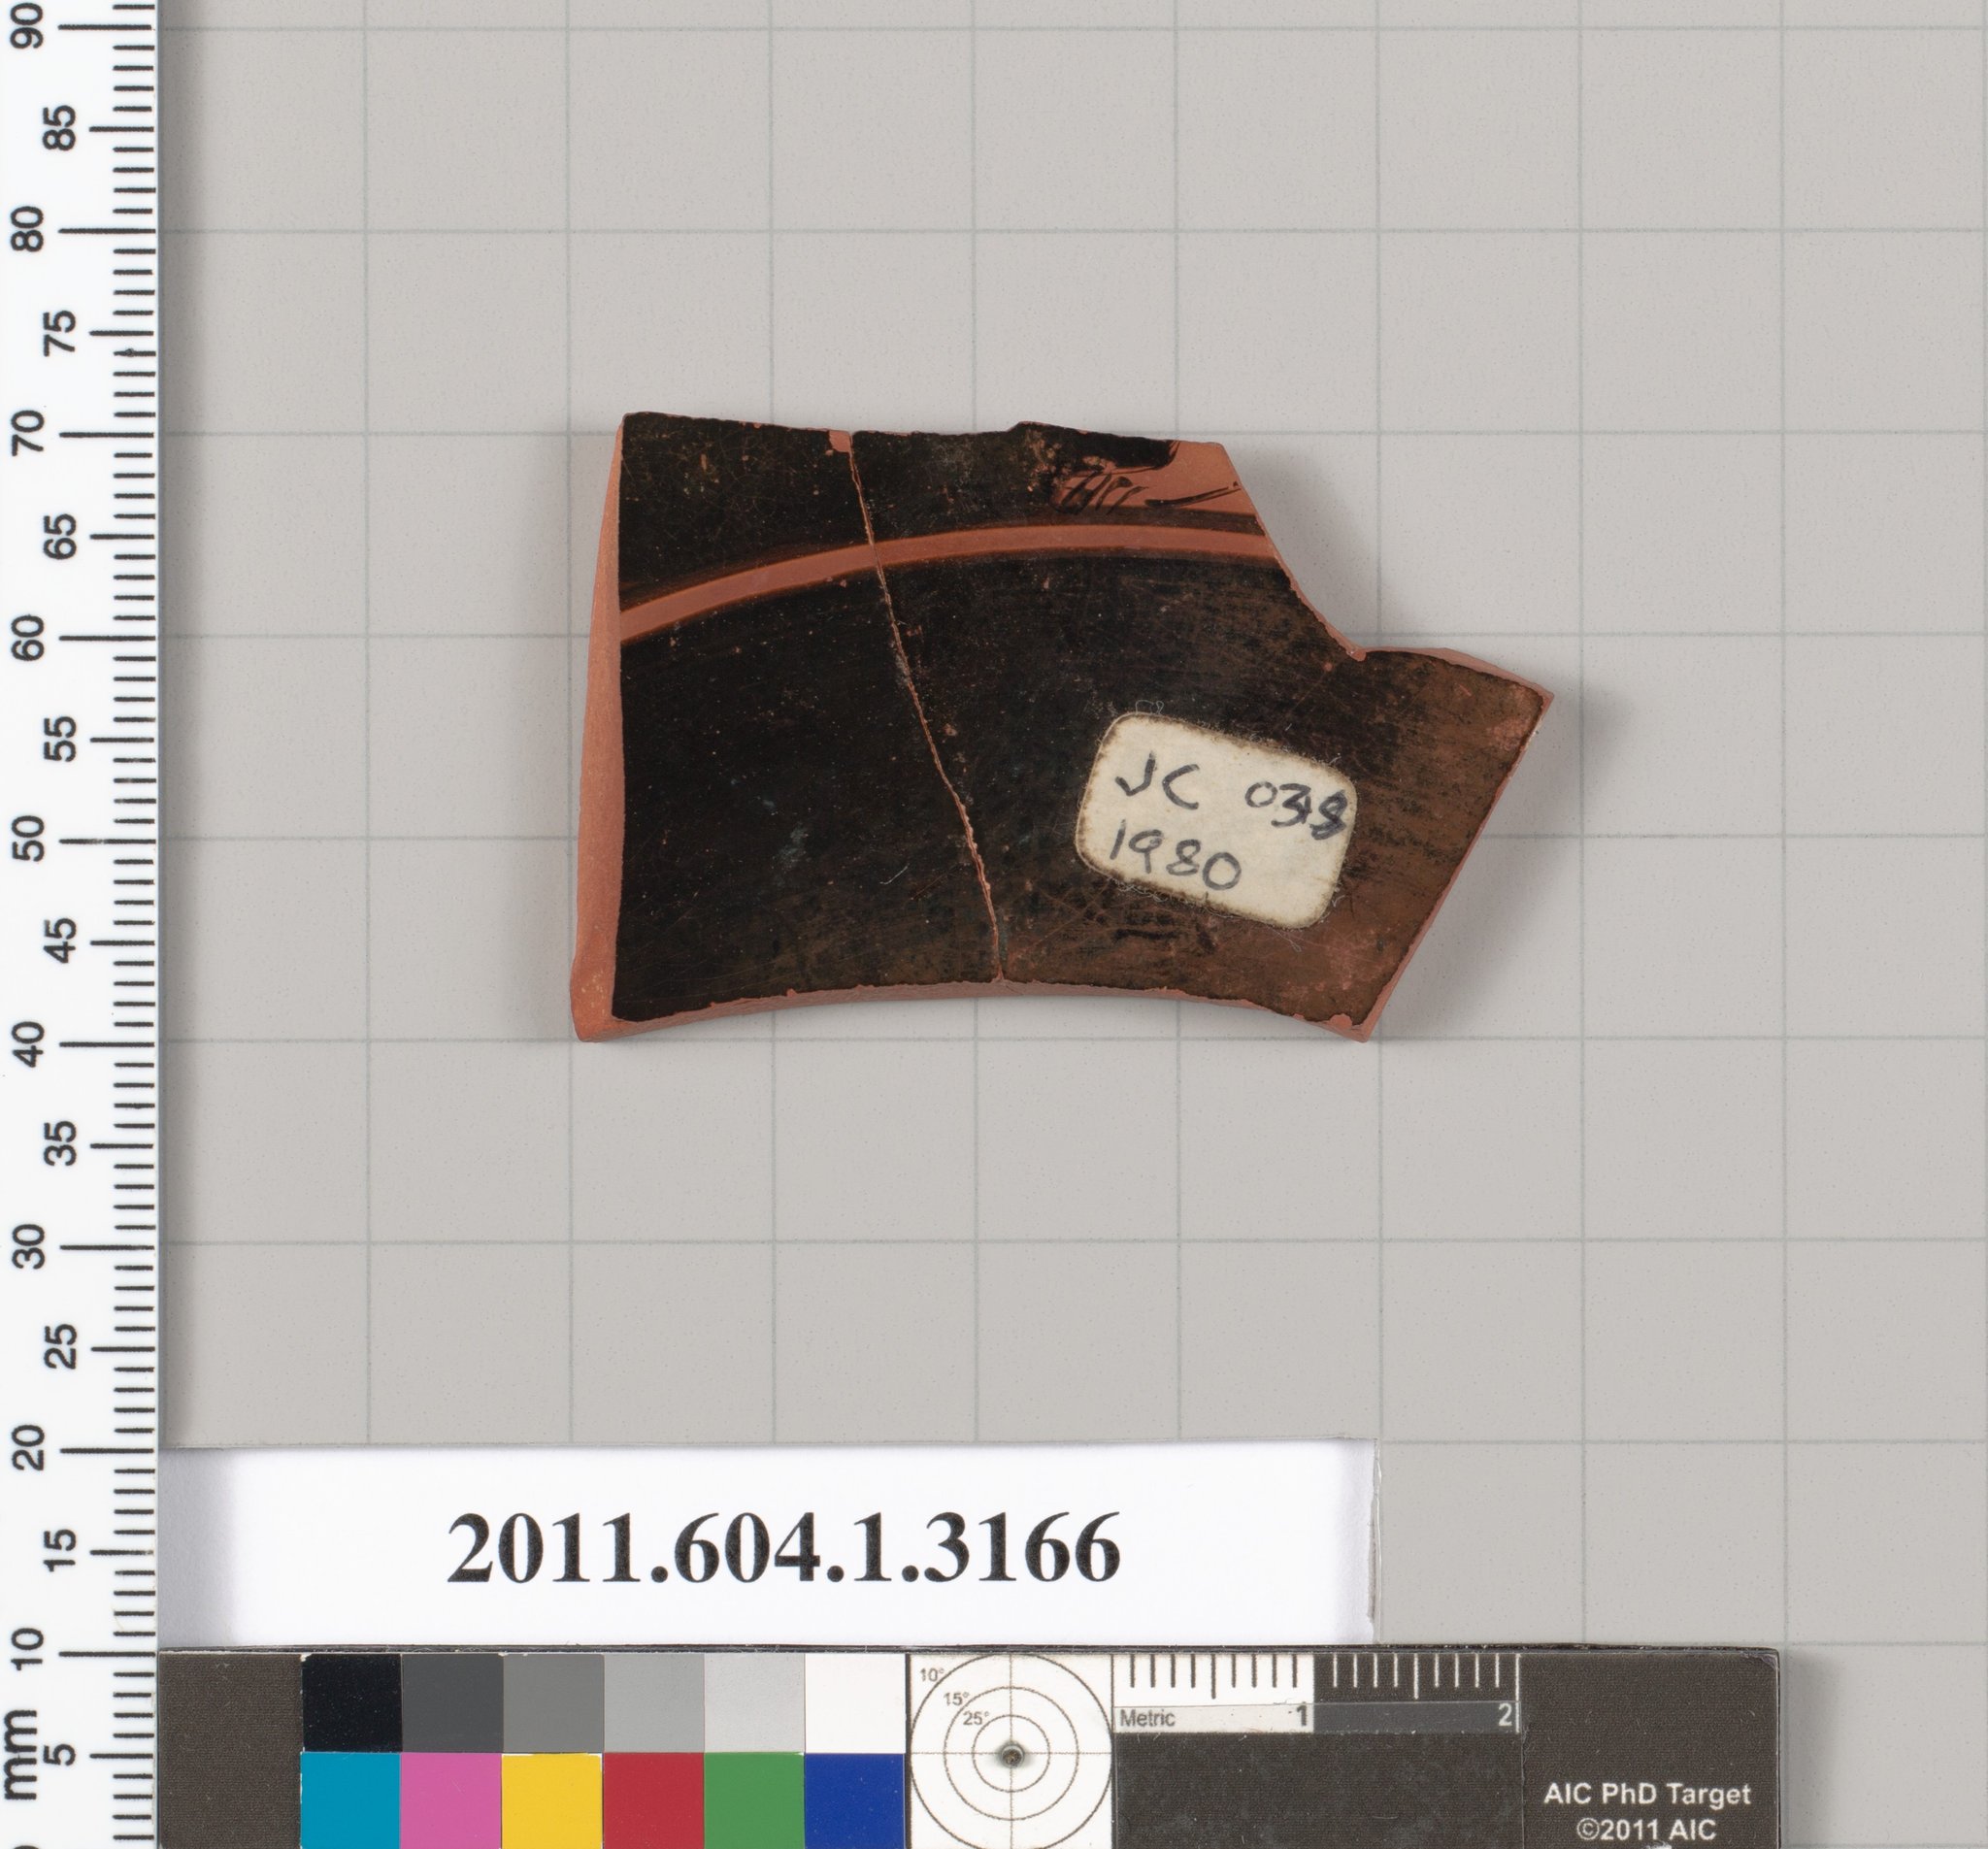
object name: kylix fragment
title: Terracotta fragment of a kylix (drinking cup)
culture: greek, attic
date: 510-490 BCE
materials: terracotta